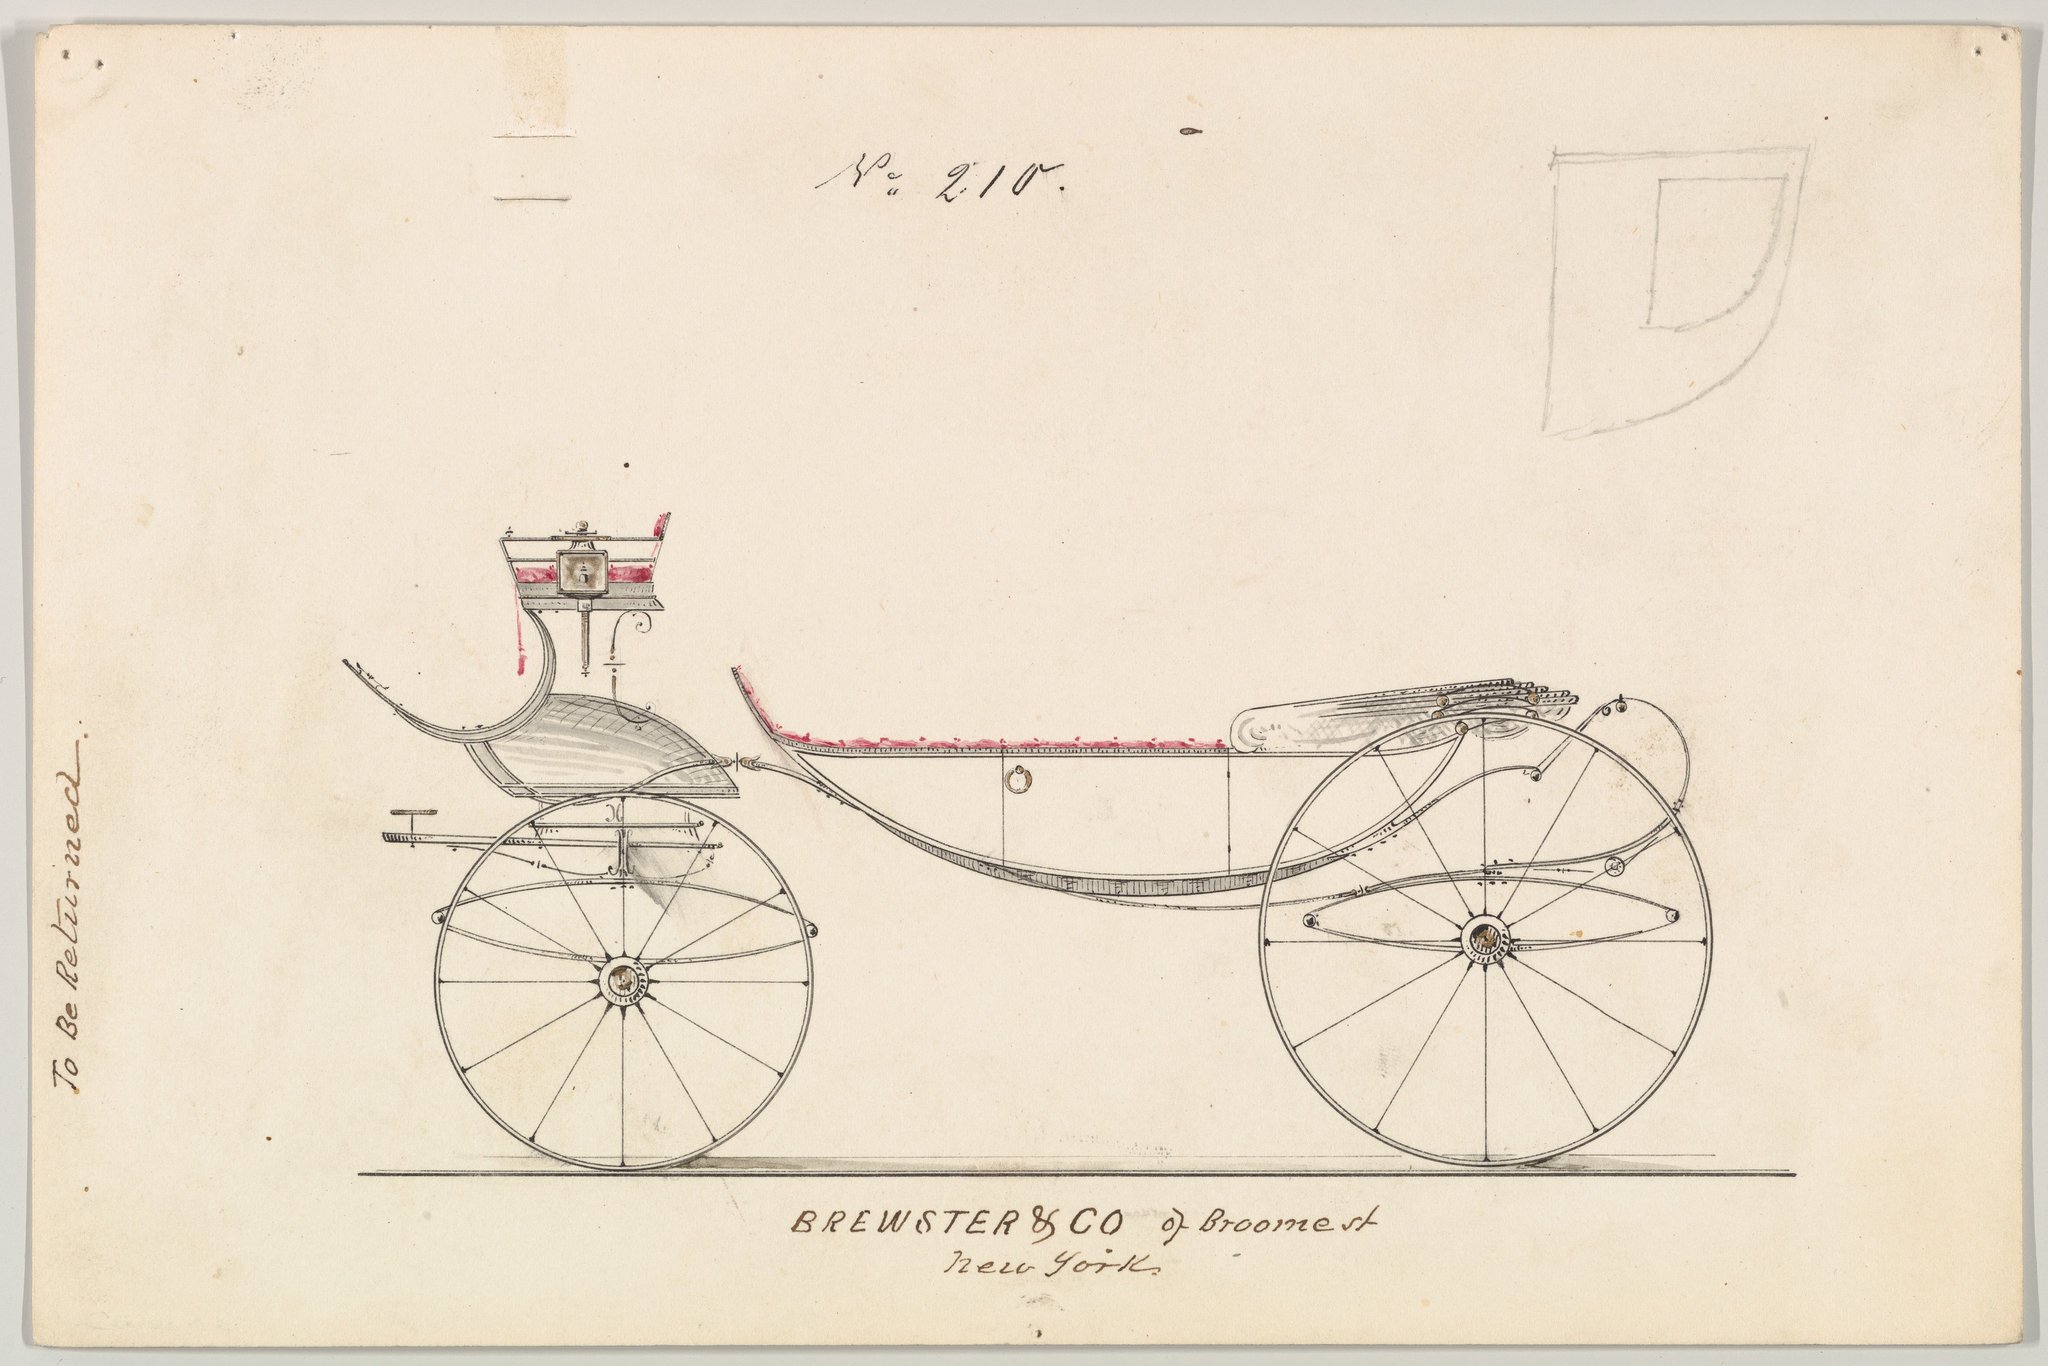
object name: drawing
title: Design for Vis-à-vis/ Barouche, no. 210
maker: brewster & co.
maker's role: manufacturer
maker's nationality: american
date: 1850-1870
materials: gouache, graphite, ink, watercolor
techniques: pen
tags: carriages